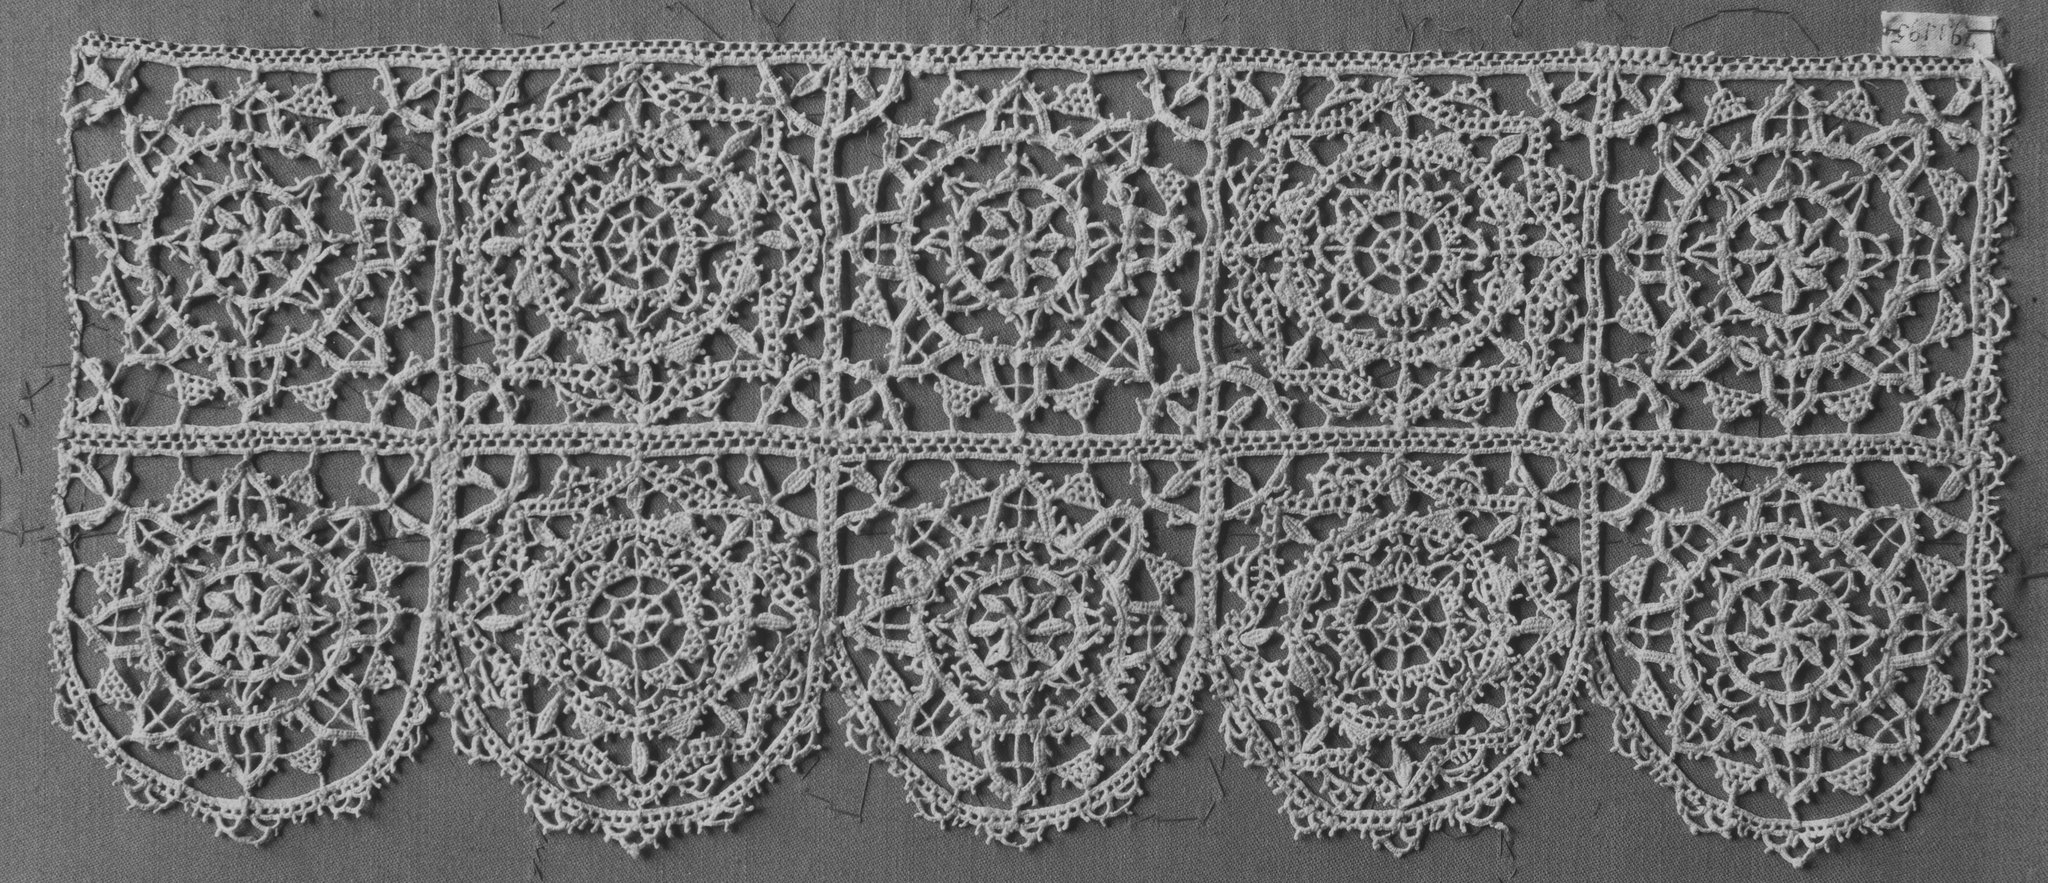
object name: fragment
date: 1601-1700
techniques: lace